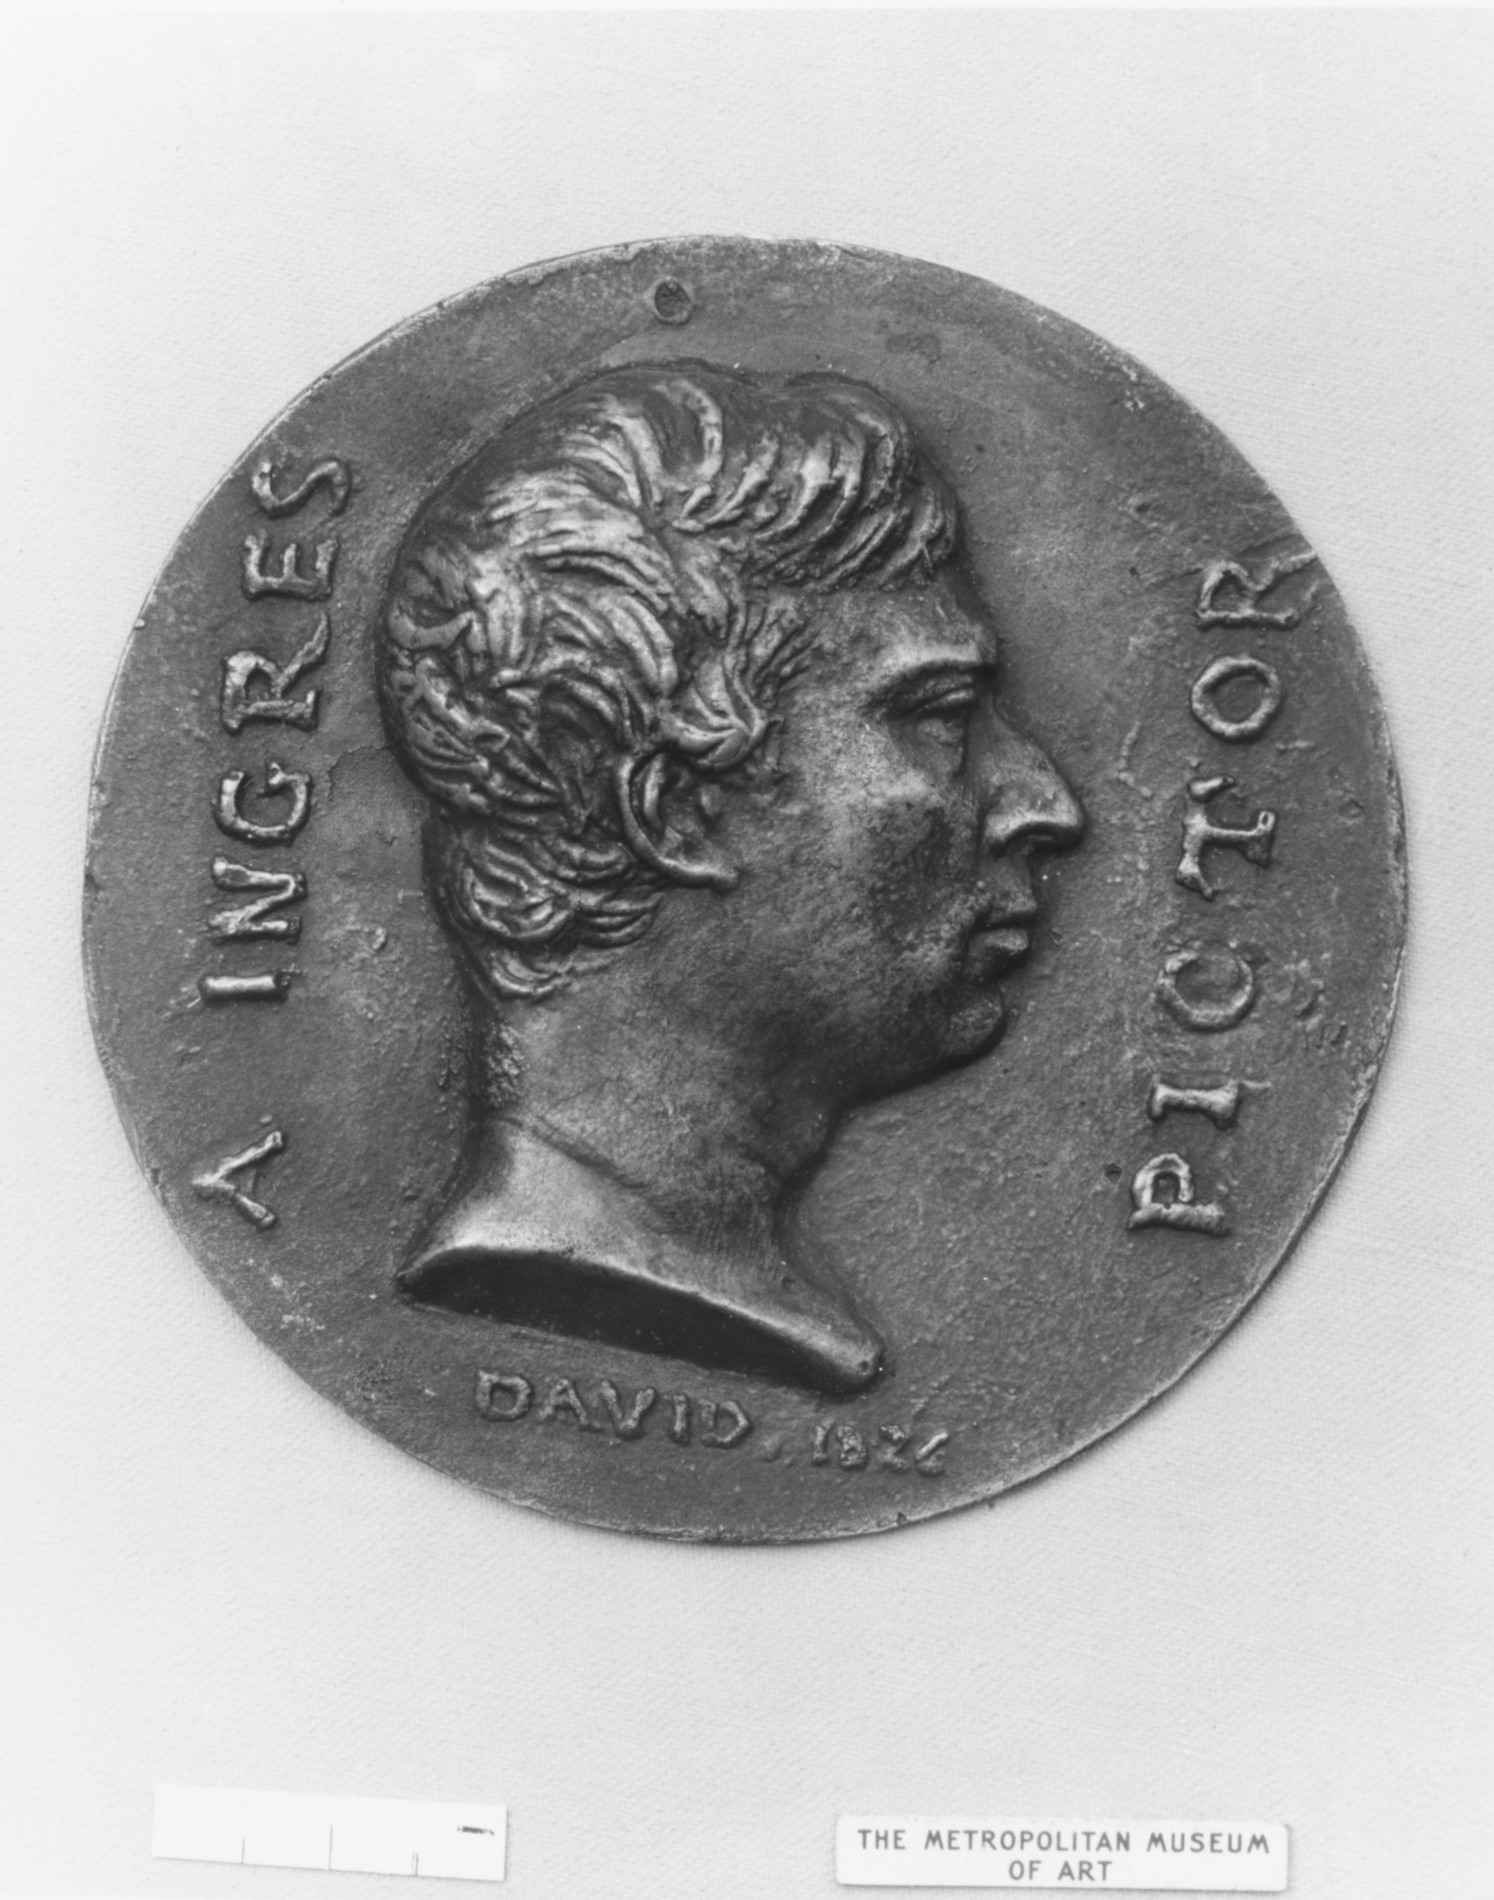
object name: medallion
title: Jean Auguste Dominique Ingres (1780–1867), French painter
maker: pierre jean david d'angers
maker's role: artist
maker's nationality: french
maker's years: 1788-1856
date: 1801-1900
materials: bronze, patina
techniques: casting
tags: men,profiles